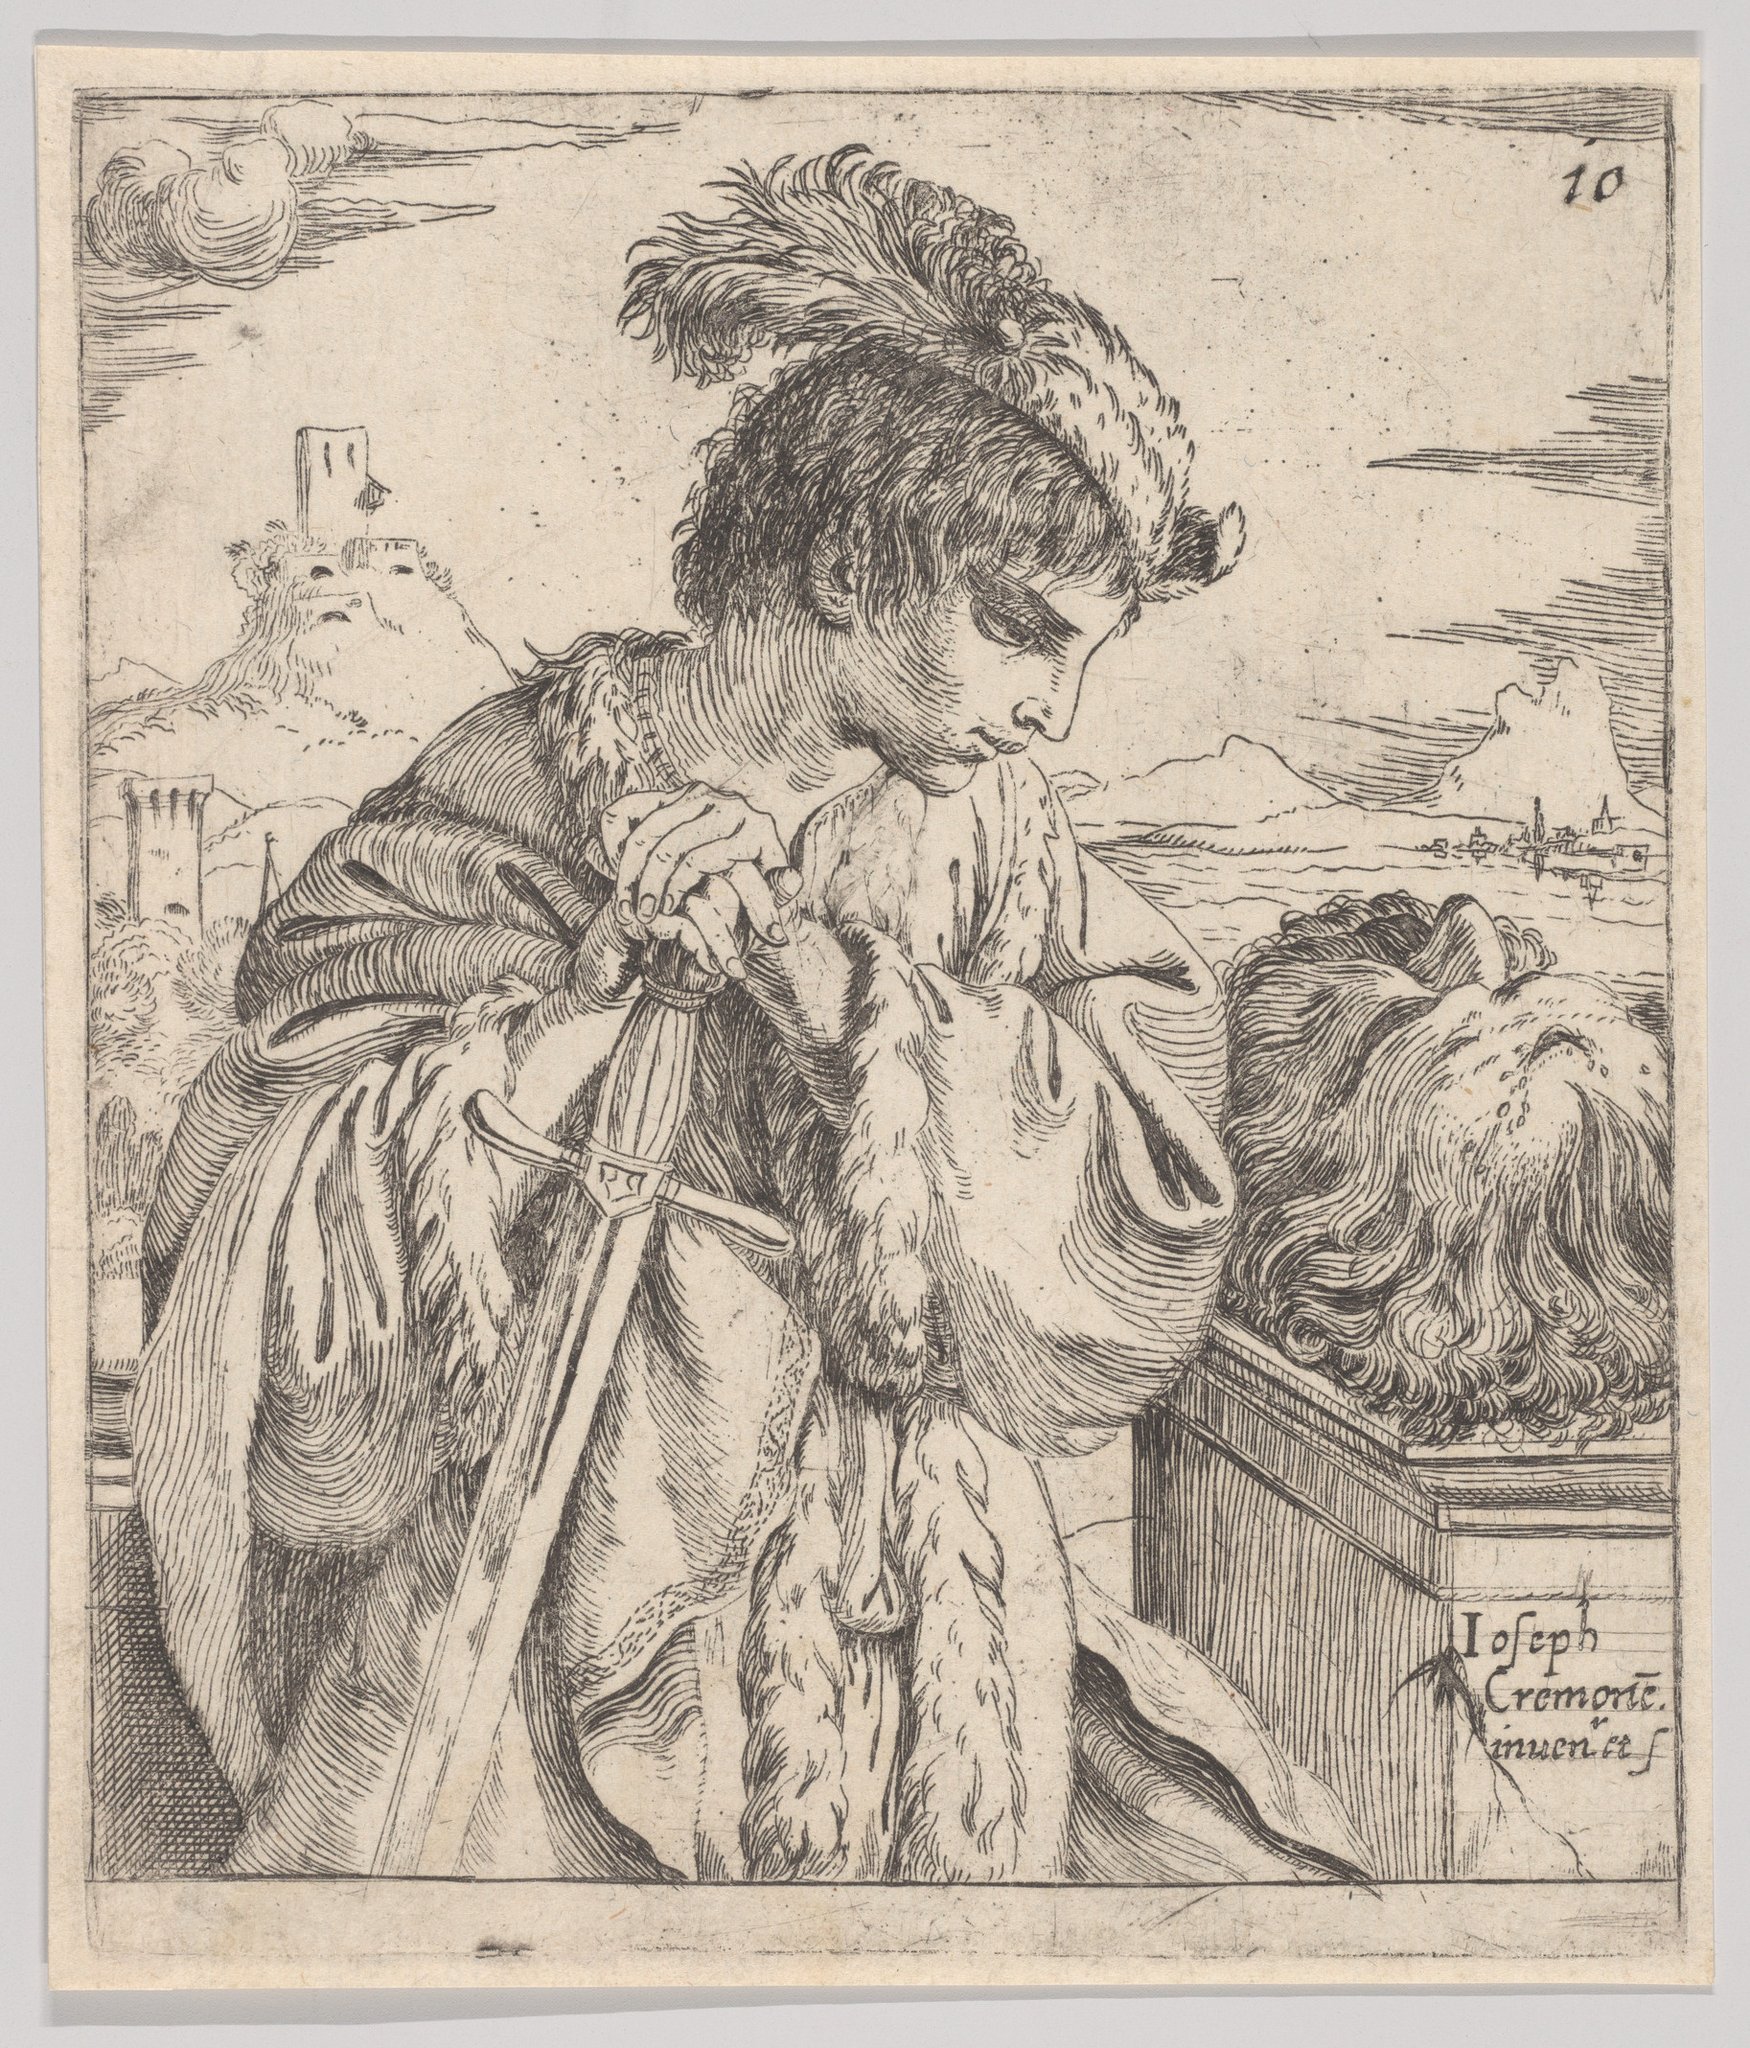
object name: print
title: David looking at the head of Goliath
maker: giuseppe caletti, called cremonese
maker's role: artist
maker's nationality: italian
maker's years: 1600-1660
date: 1620-1630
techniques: etching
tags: heads,david,goliath